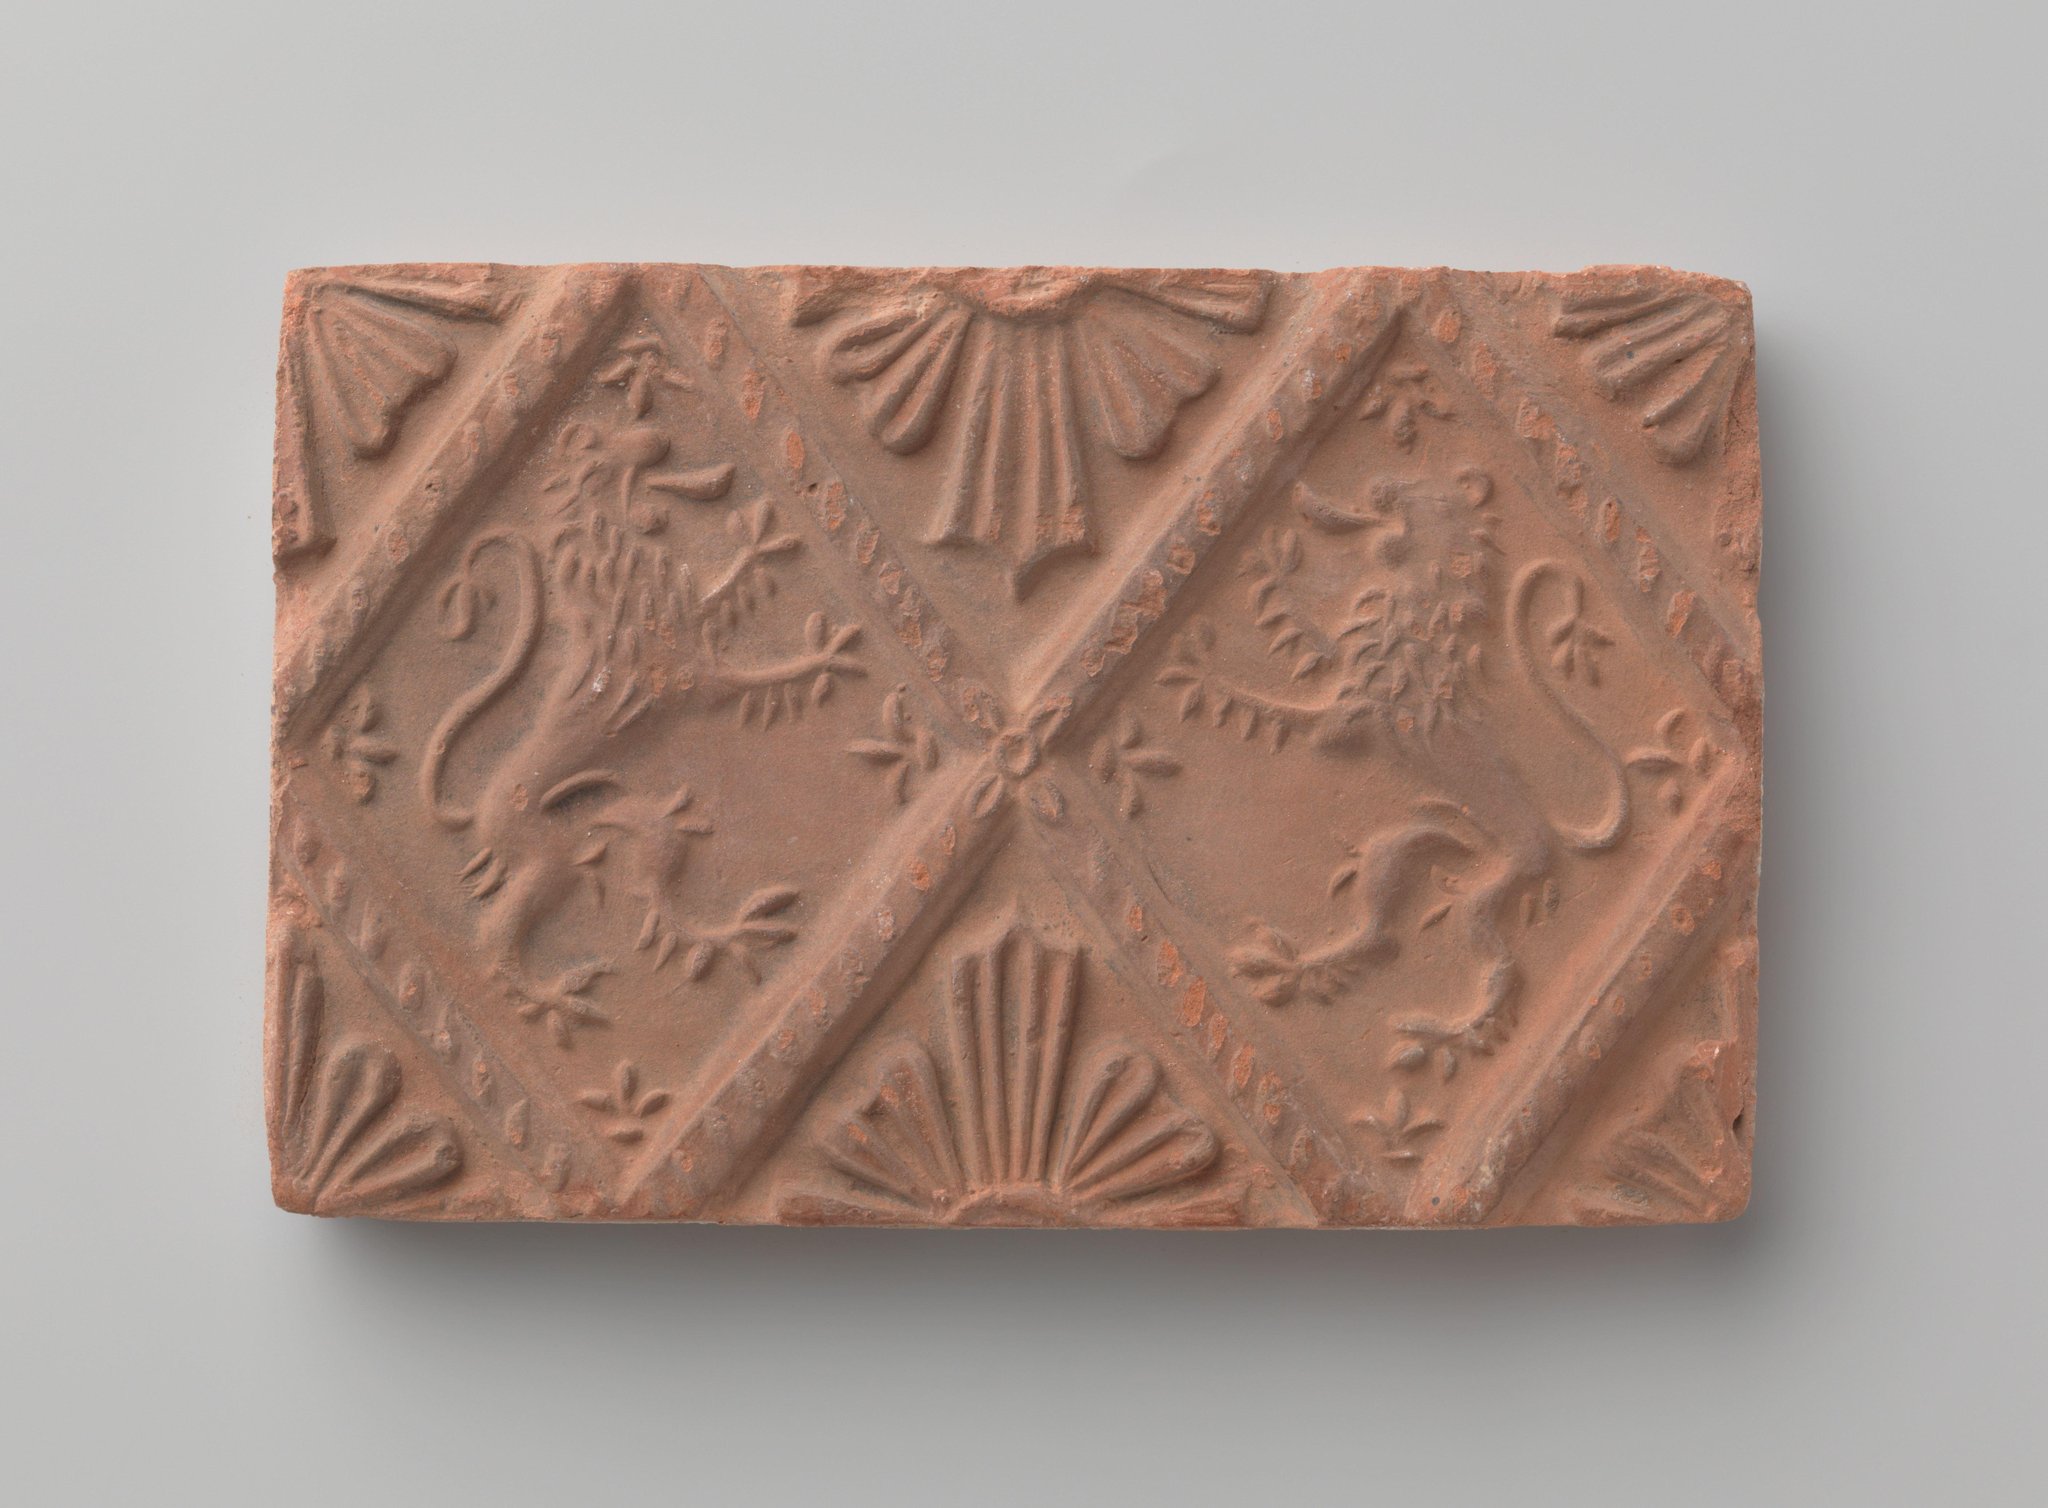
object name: hearthstone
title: Haardsteen met voorstelling van twee klimmende leeuwen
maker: Anonymous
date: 1875-1900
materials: earthenware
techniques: printing, firing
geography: netherlands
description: Haardsteen met voorstelling van twee klimmende leeuwen, geplaatst in geprofileerde ruit. De halve ruiten aan de boven- en onderkant zijn opgevuld met stermotief.